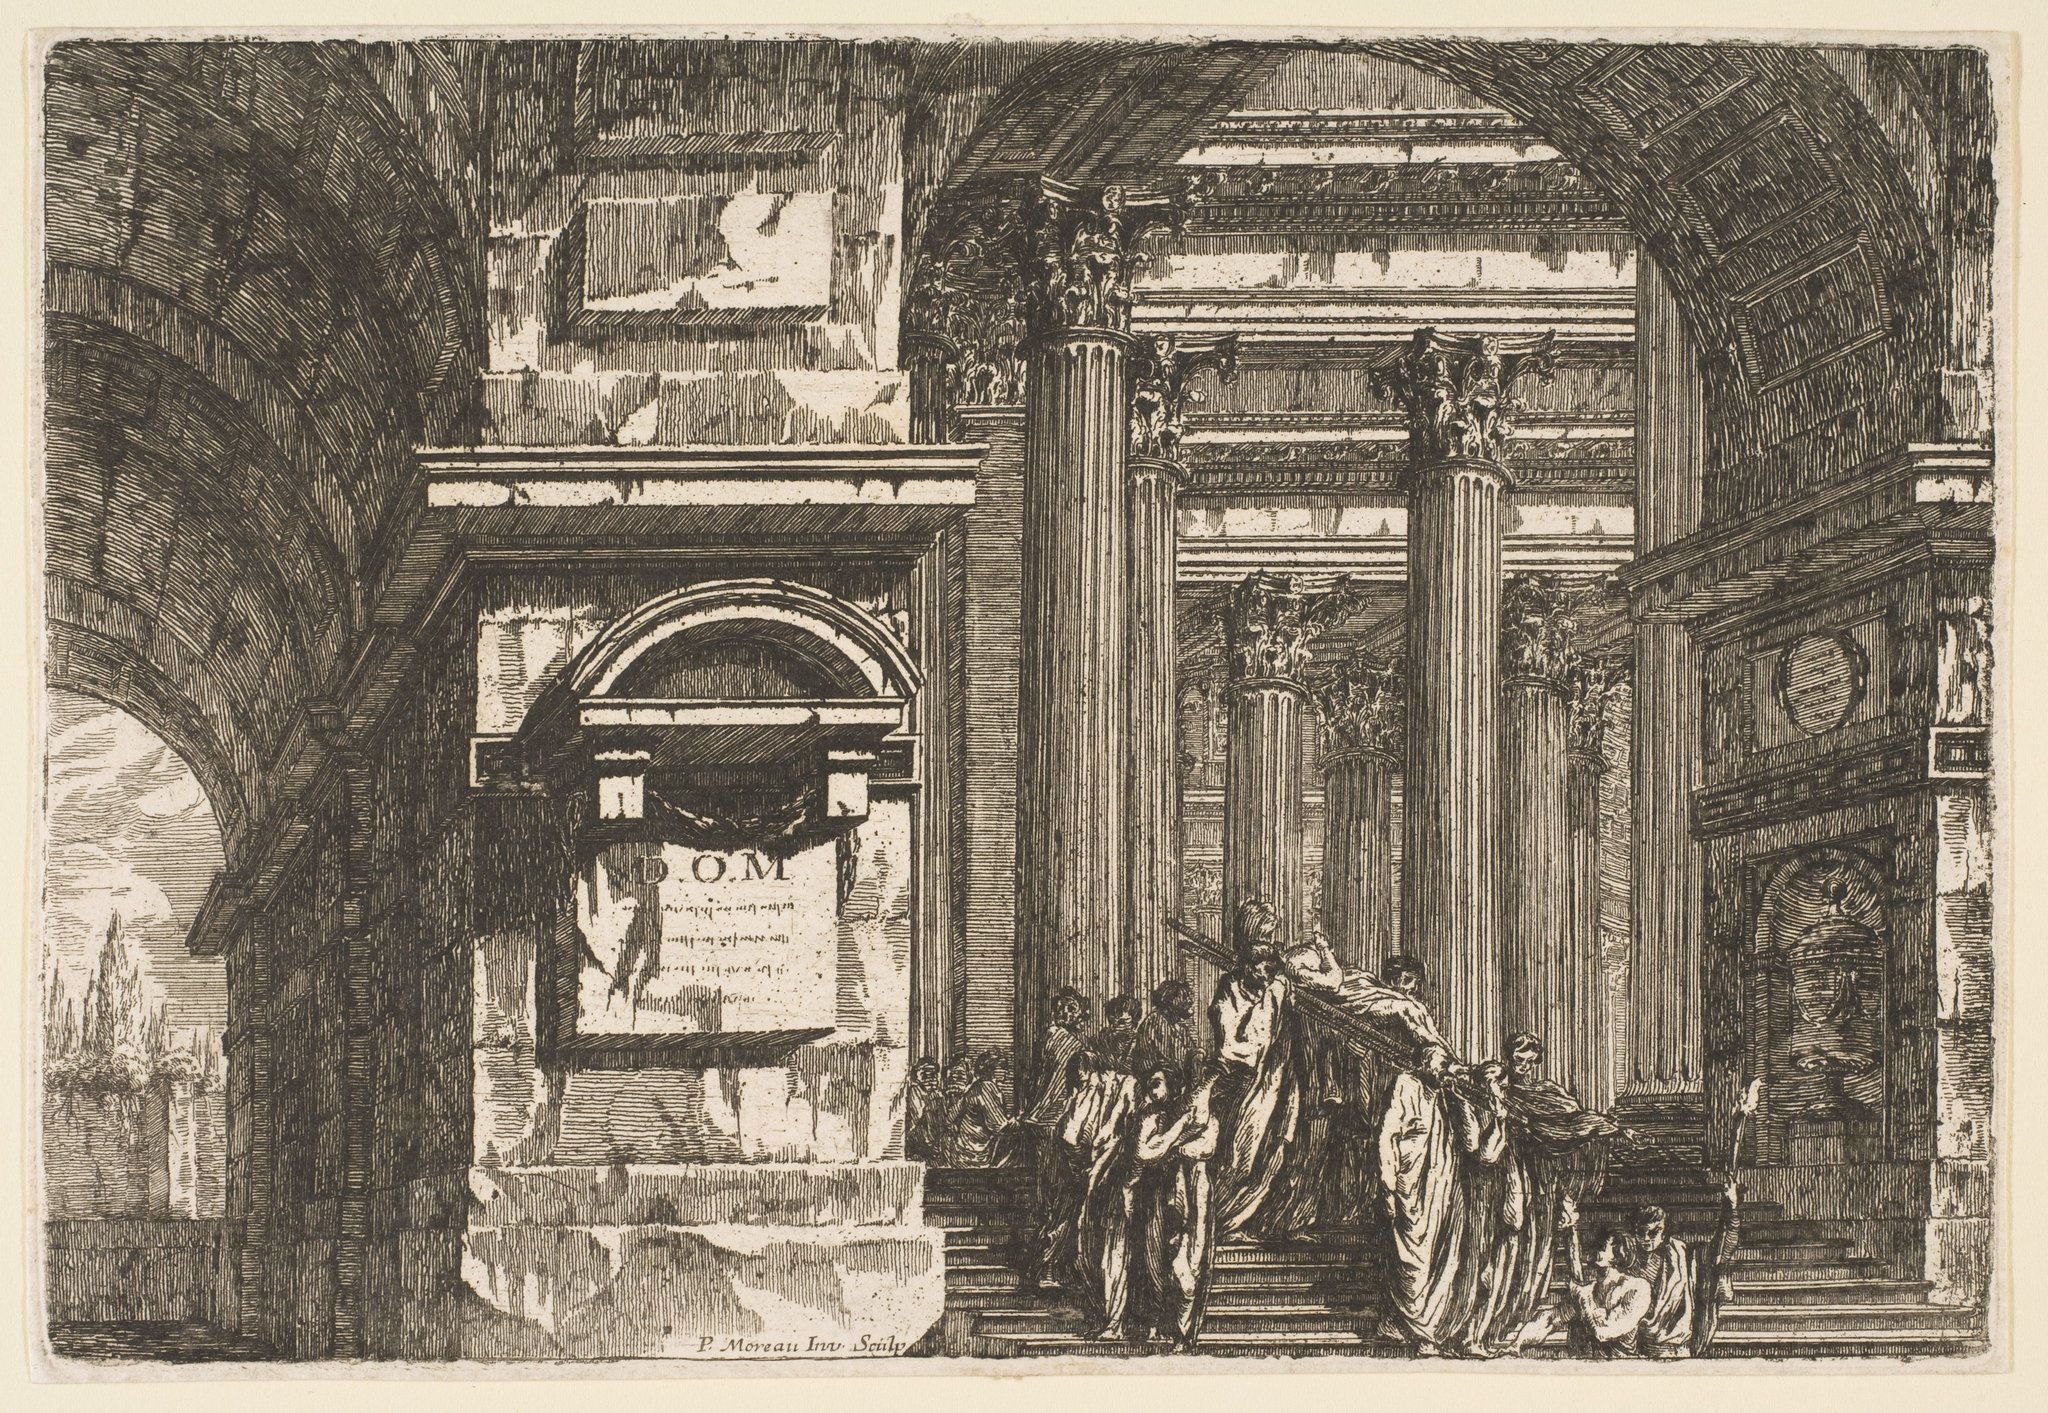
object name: print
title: Funerary Scene in a Temple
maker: pierre moreau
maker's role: artist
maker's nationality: french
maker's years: 1715-1798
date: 1760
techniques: etching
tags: human figures,temples,funerals,death